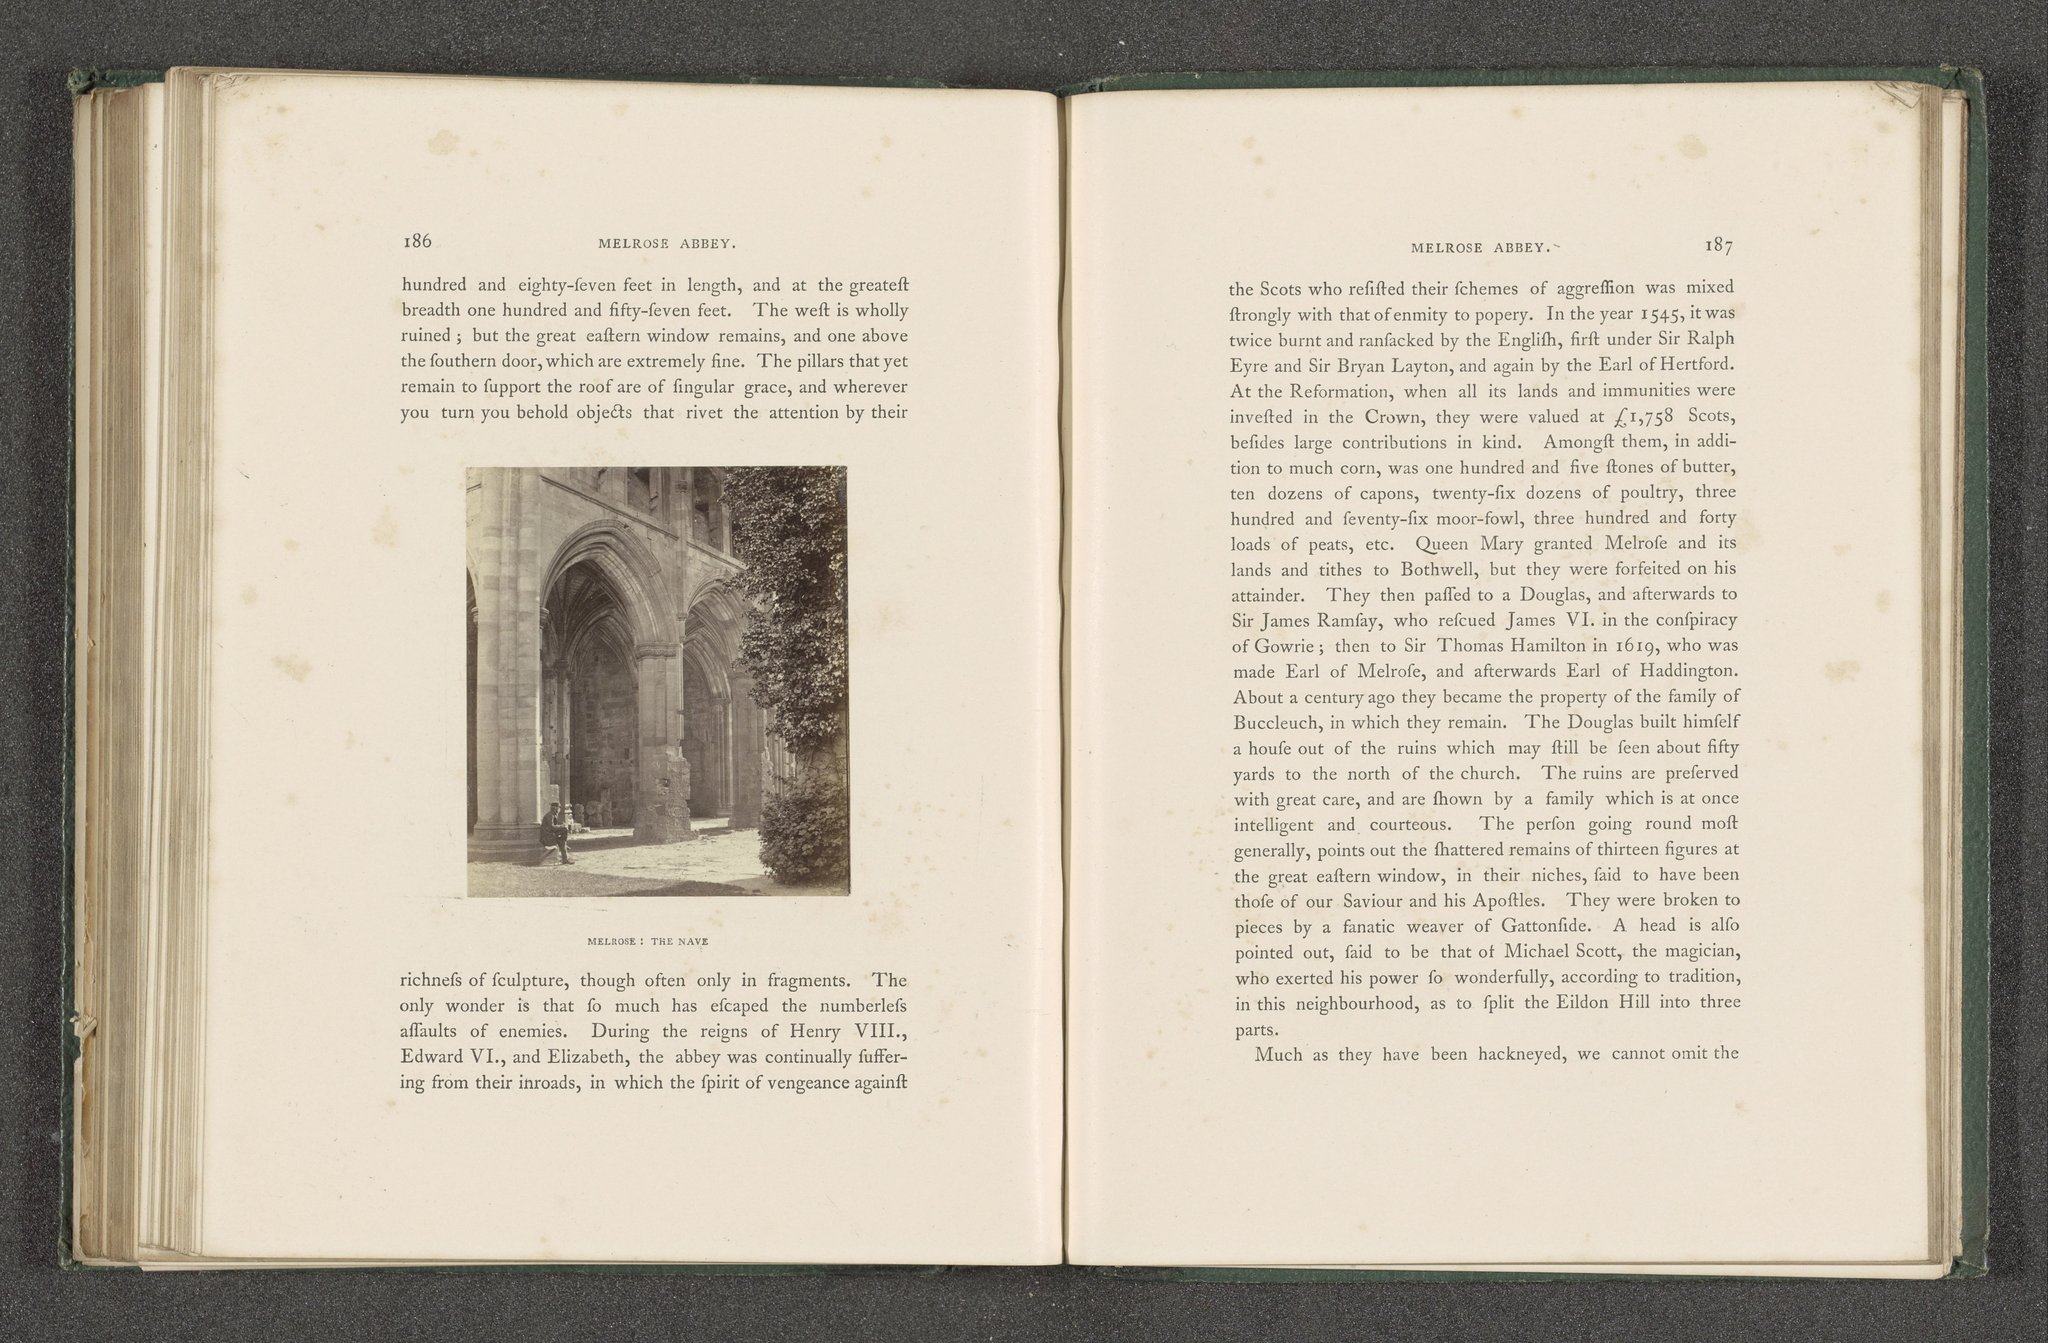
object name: photograph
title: Exterieur van het schip van de Melrose Abbey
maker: george washington wilson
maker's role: publisher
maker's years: 1823-1893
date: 1852-1862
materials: photographic support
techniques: albumen print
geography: melrose abbey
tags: ruin of church, monastery, etc., parts of church interior: nave